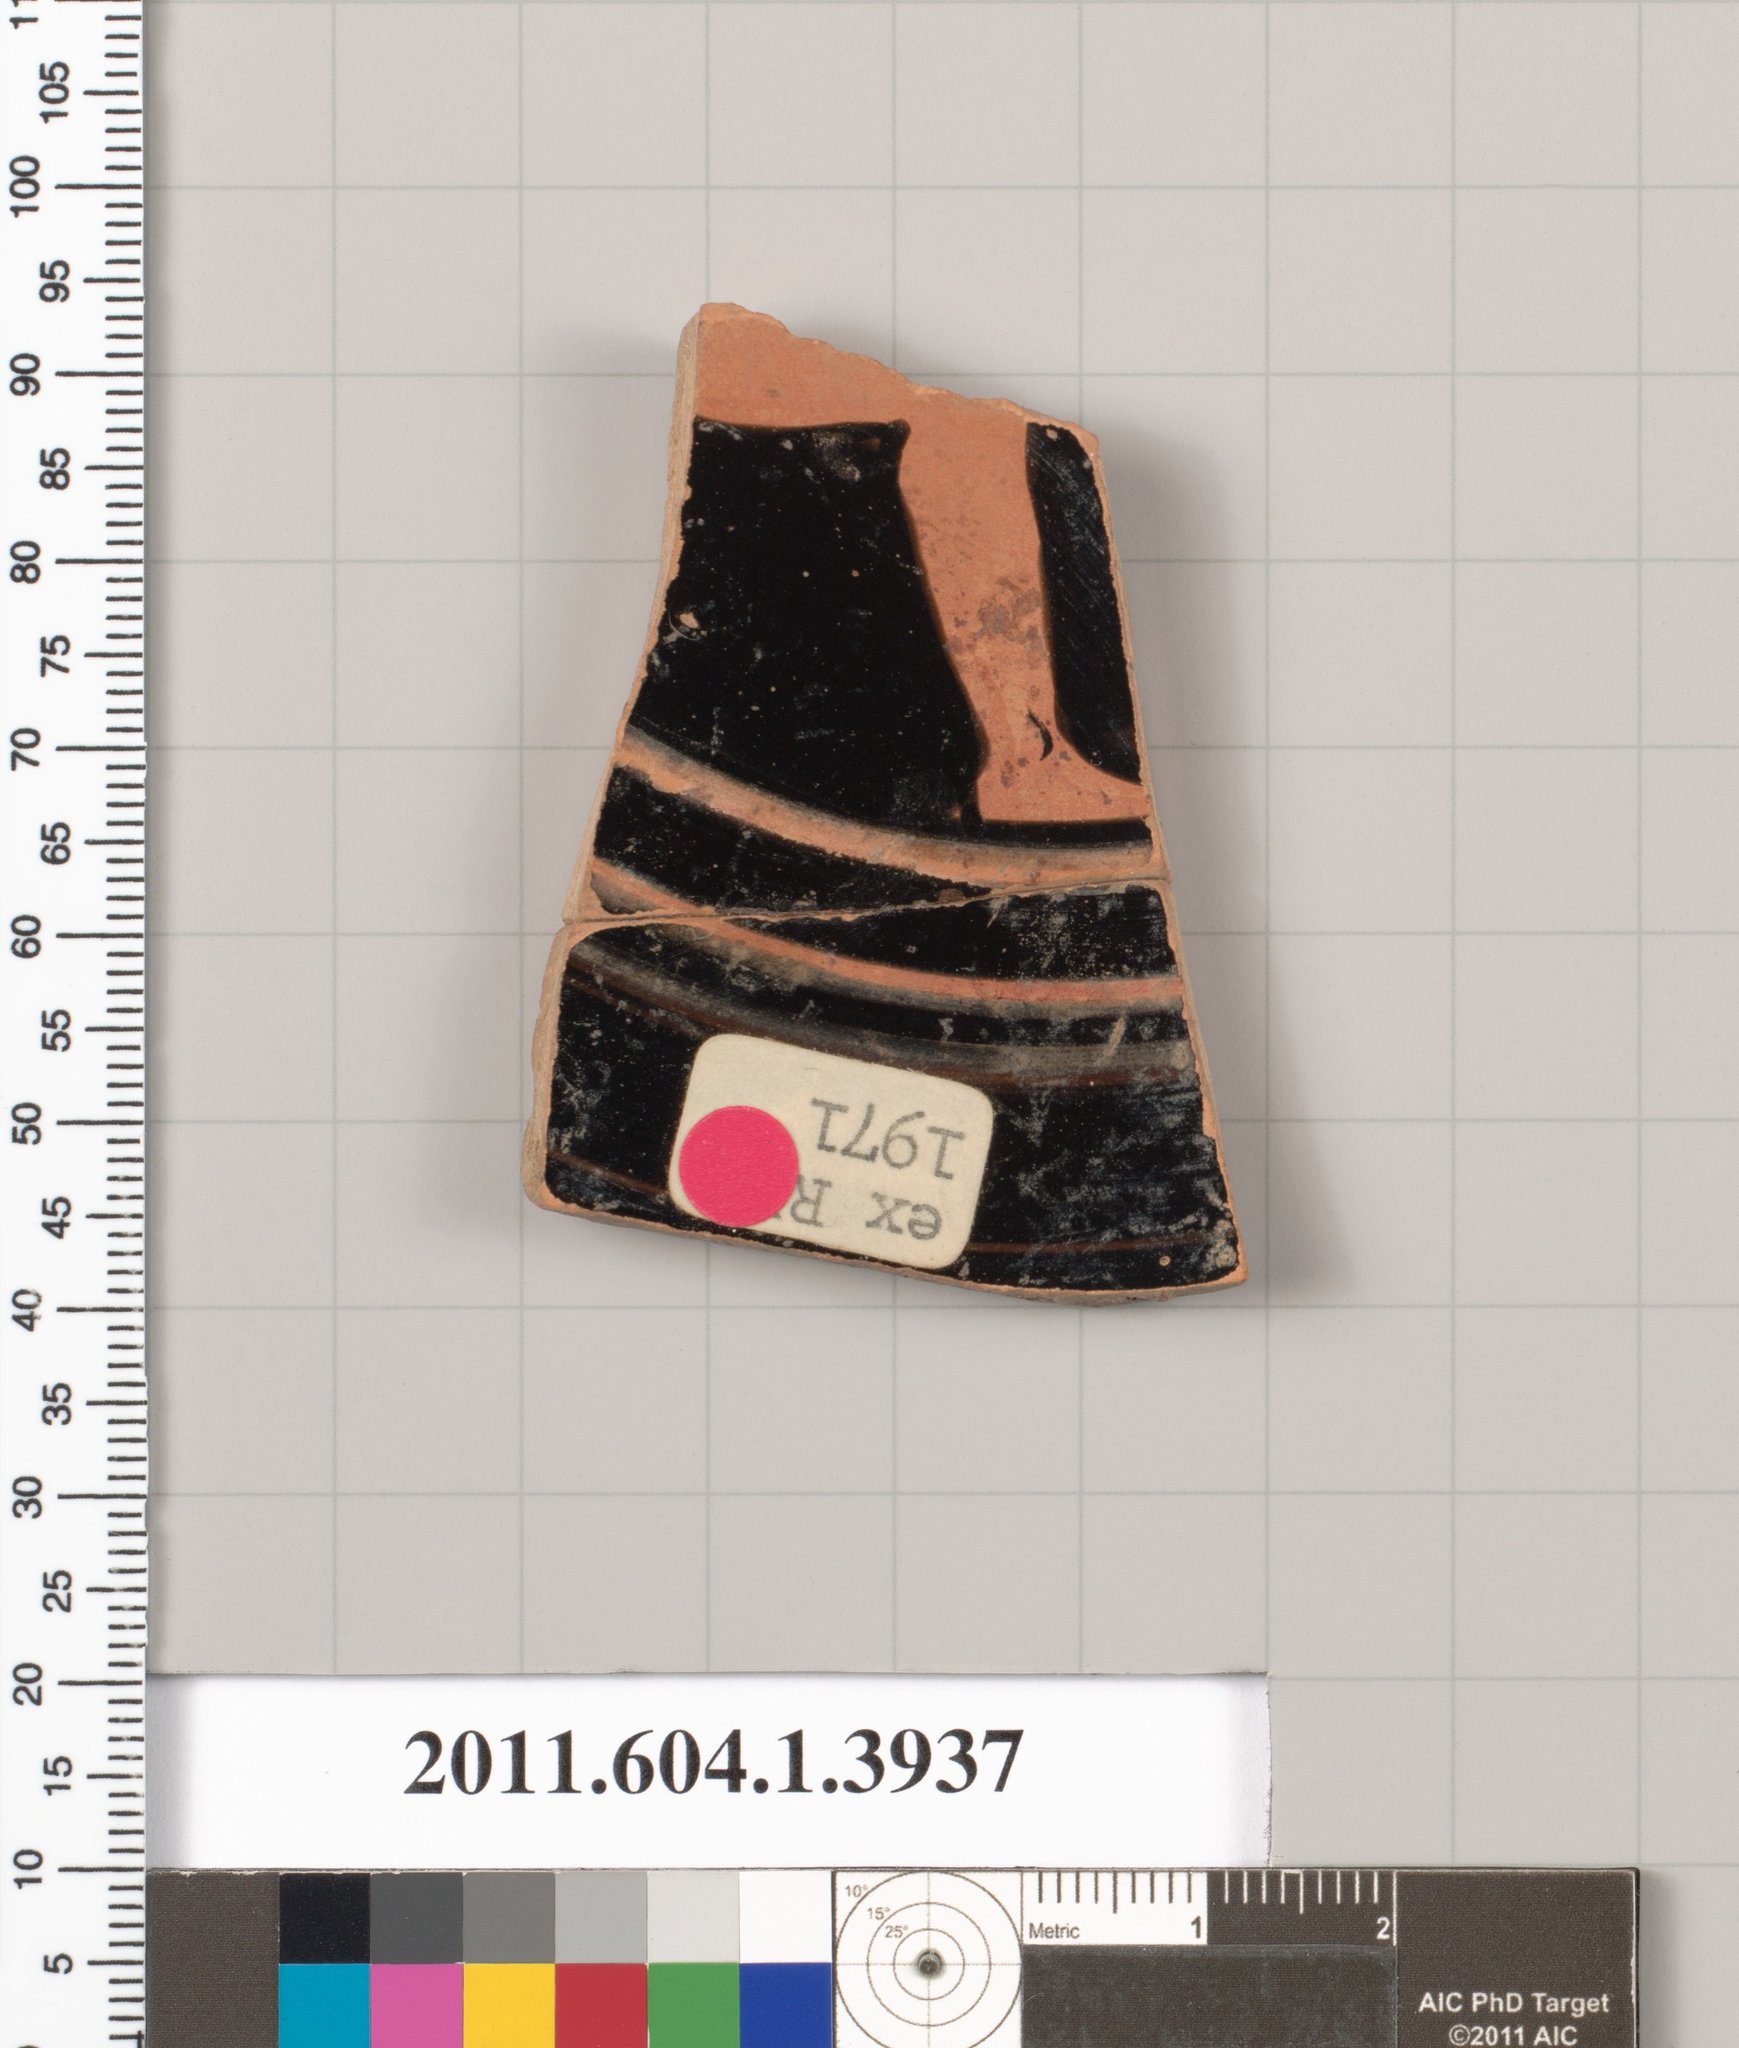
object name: kylix fragment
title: Terracotta fragment of a kylix (drinking cup)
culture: greek, attic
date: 500-470 BCE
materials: terracotta